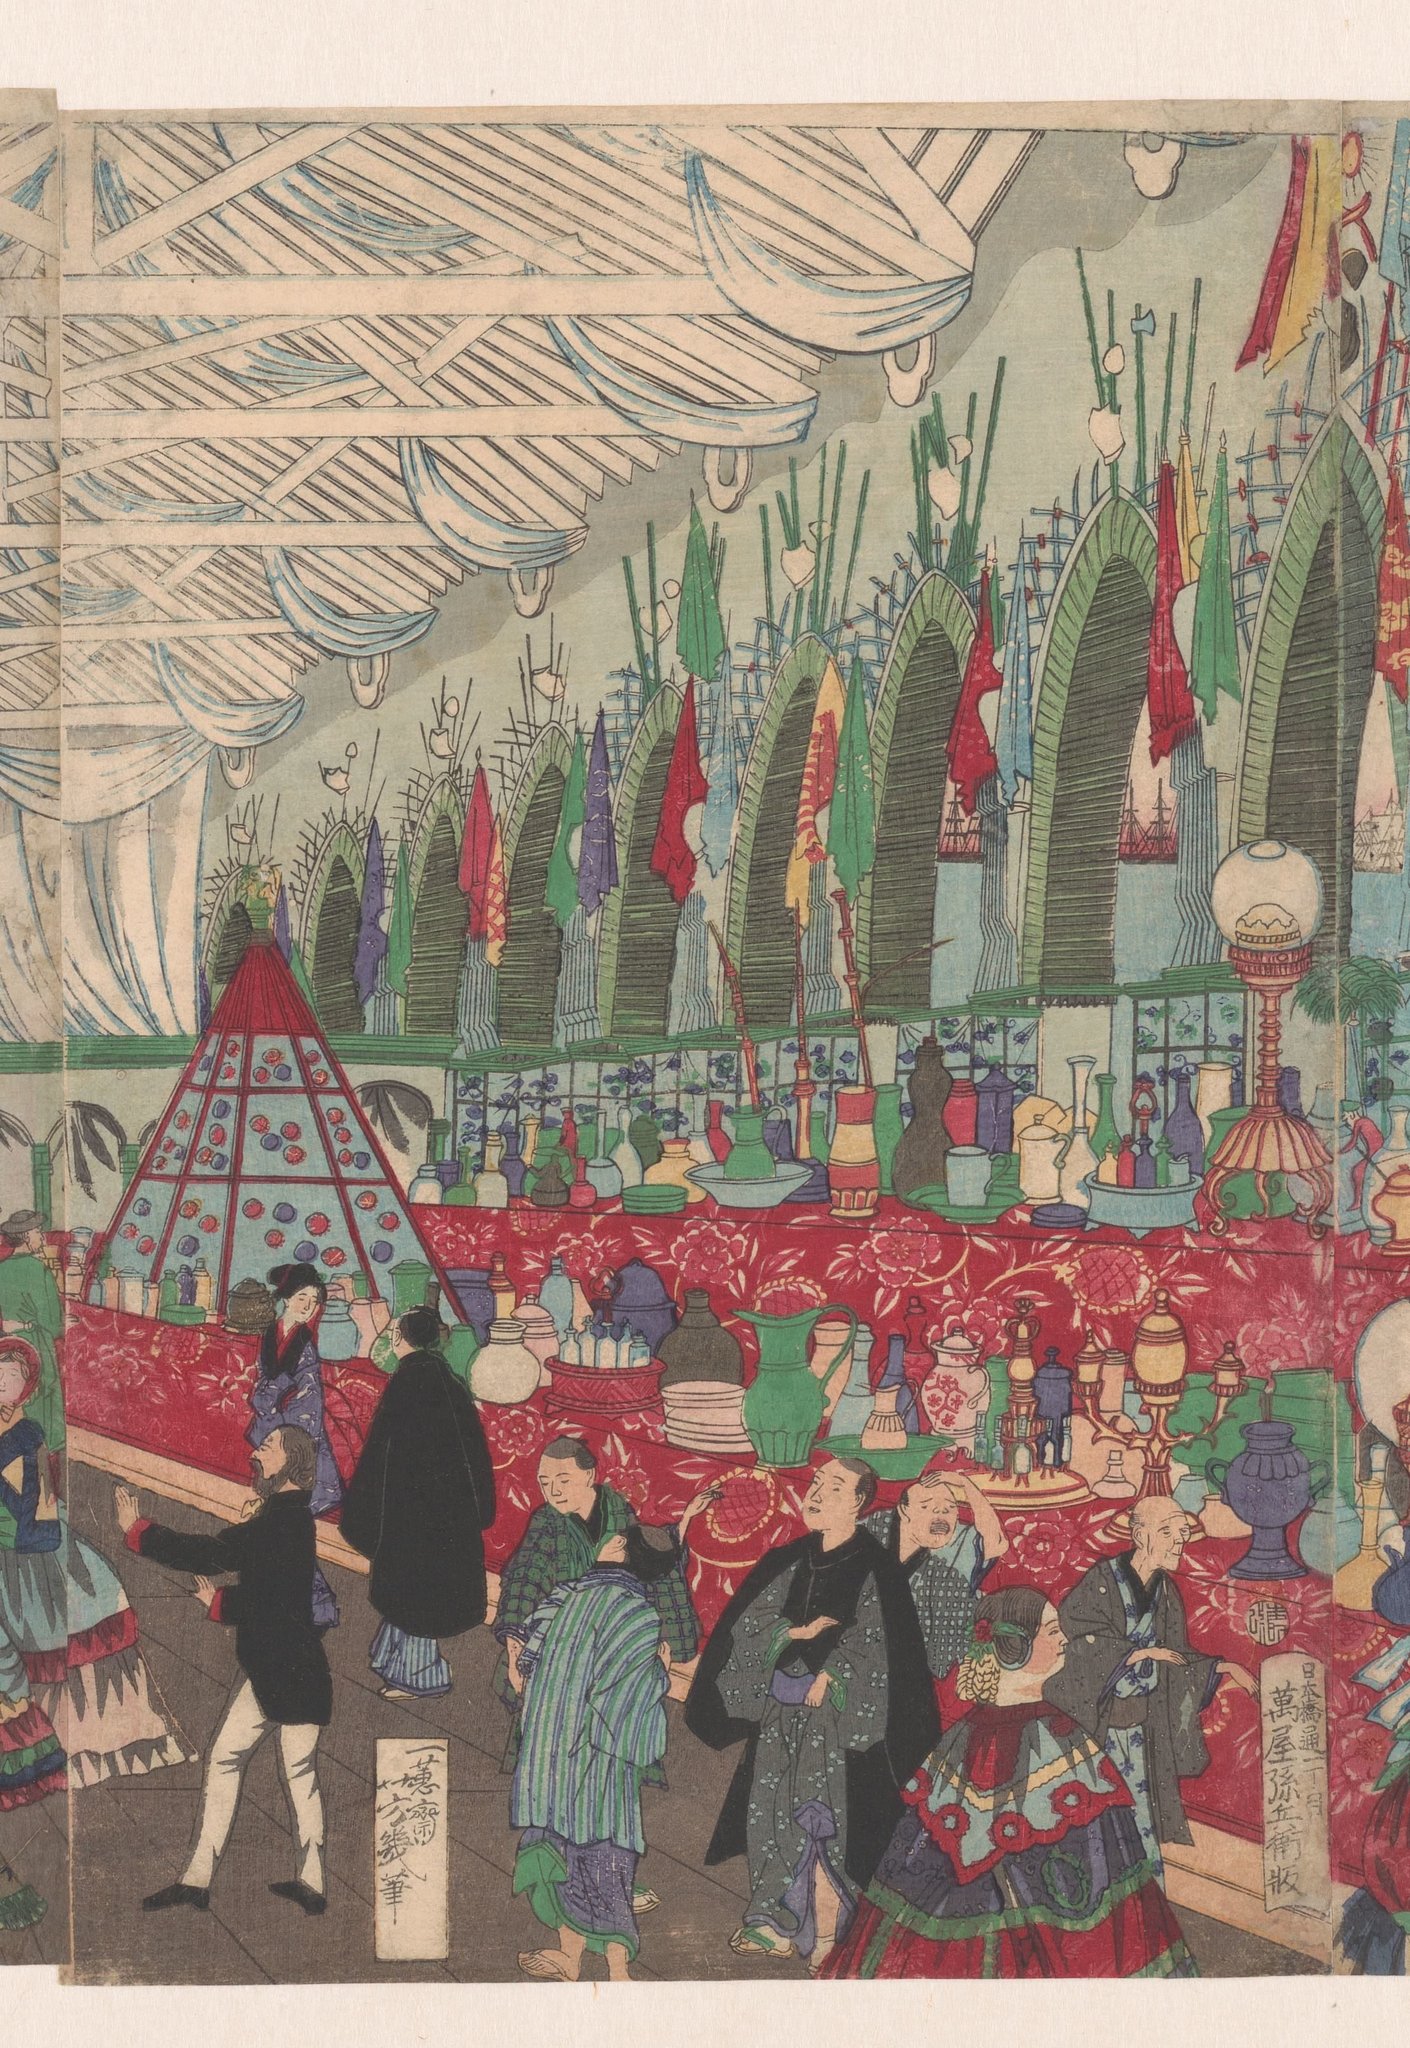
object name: print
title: Een florerend Engels handelshuis in Yokohama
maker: utagawa yoshiiku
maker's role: draughtsman, print maker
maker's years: 1833-1904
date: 1808-1871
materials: paper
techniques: woodcut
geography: japan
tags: locations for trading, market-hall